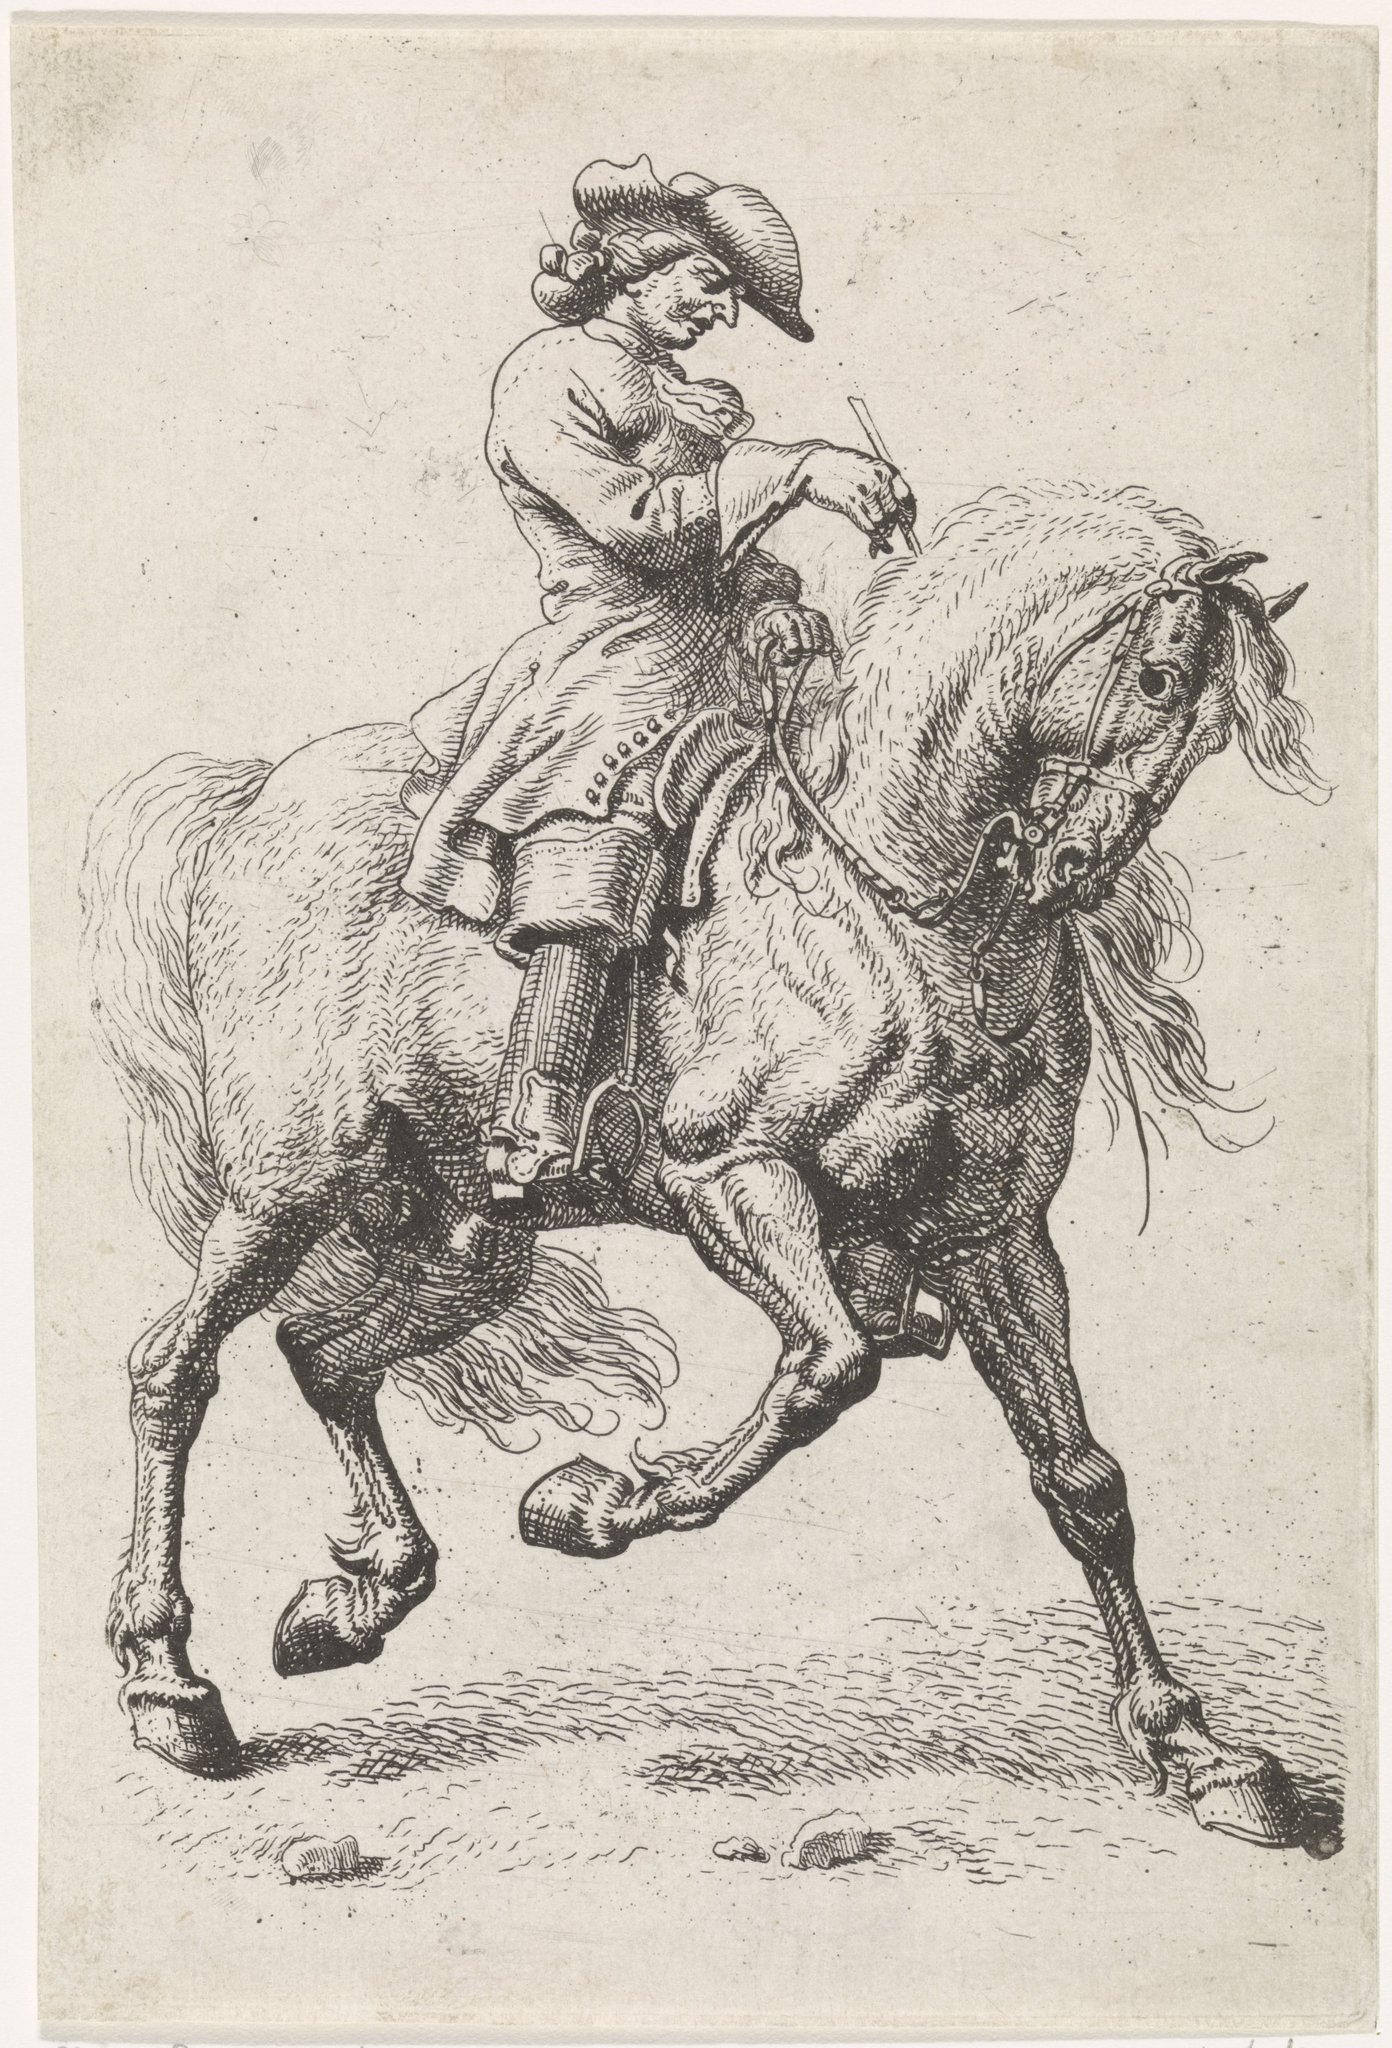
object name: print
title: Trainen van paarden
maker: dirk maas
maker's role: draughtsman, print maker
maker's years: 1659-1717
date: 1669-1717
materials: paper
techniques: etching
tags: training of horses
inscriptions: collector's mark: Lugt 2228, collector's mark: Lugt 2610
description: Ruiter naar rechts, laat zijn paard naar achter lopen. Prent van een serie van twee prenten met ruiters die hun paarden trainen.